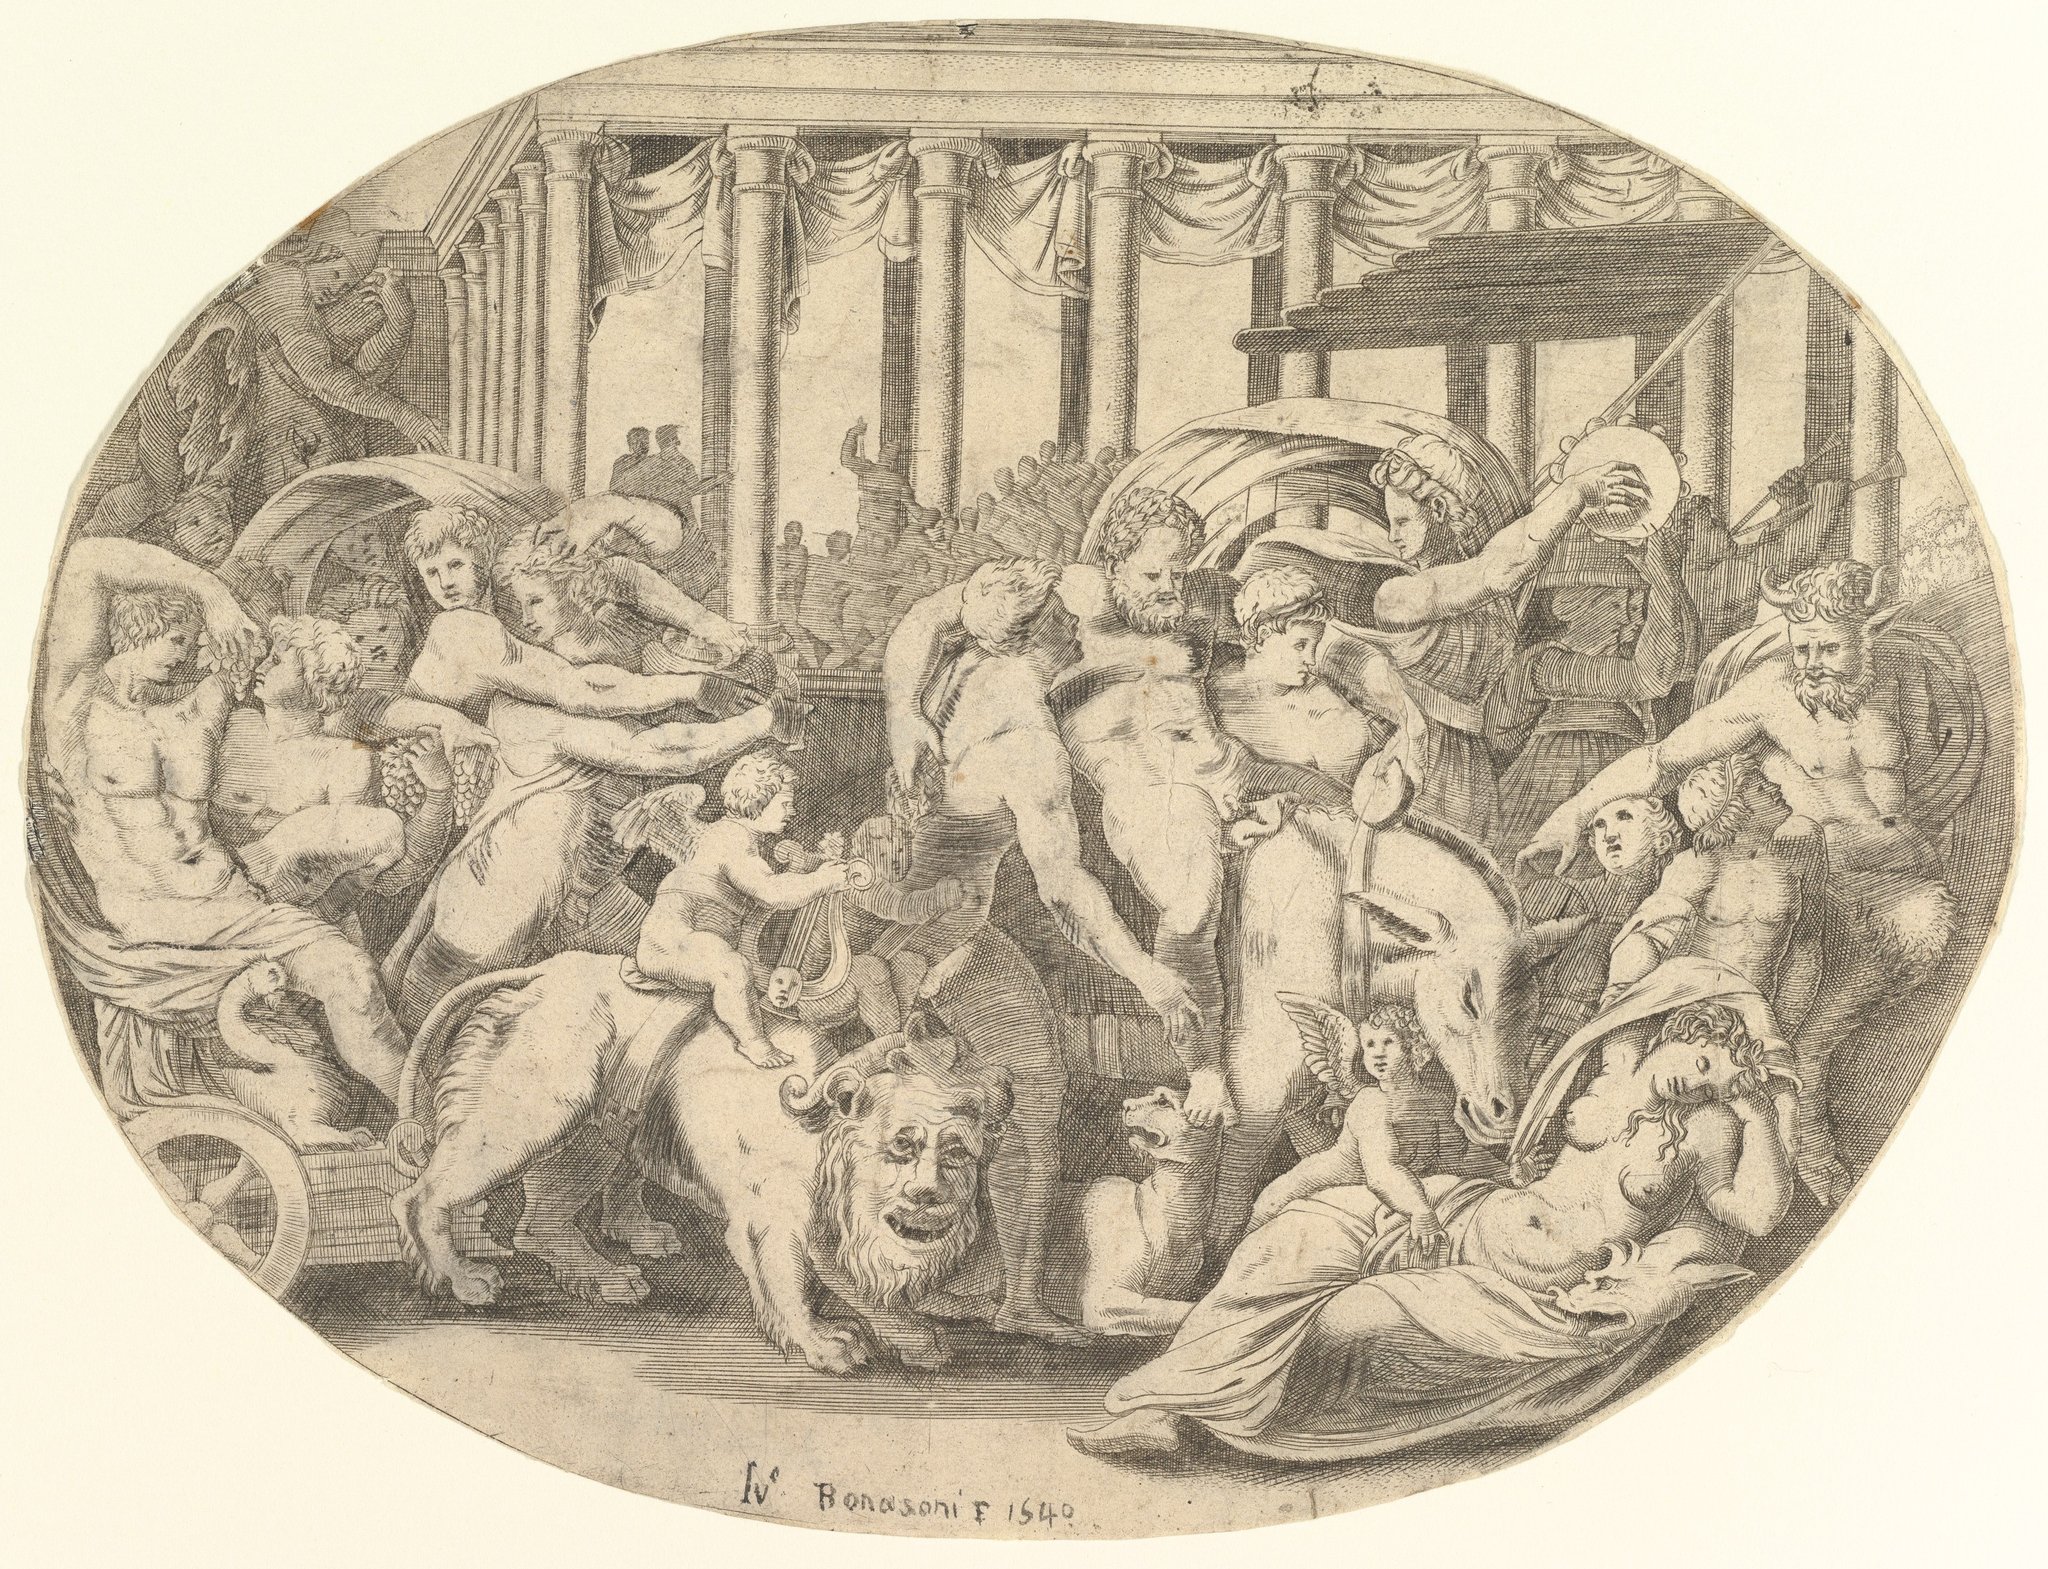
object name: print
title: The Triumph of Bacchus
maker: anonymous, italian?, 16th century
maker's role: artist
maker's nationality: italian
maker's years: 1500-1600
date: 1501-1600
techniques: engraving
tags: women,bacchus,horses,lions